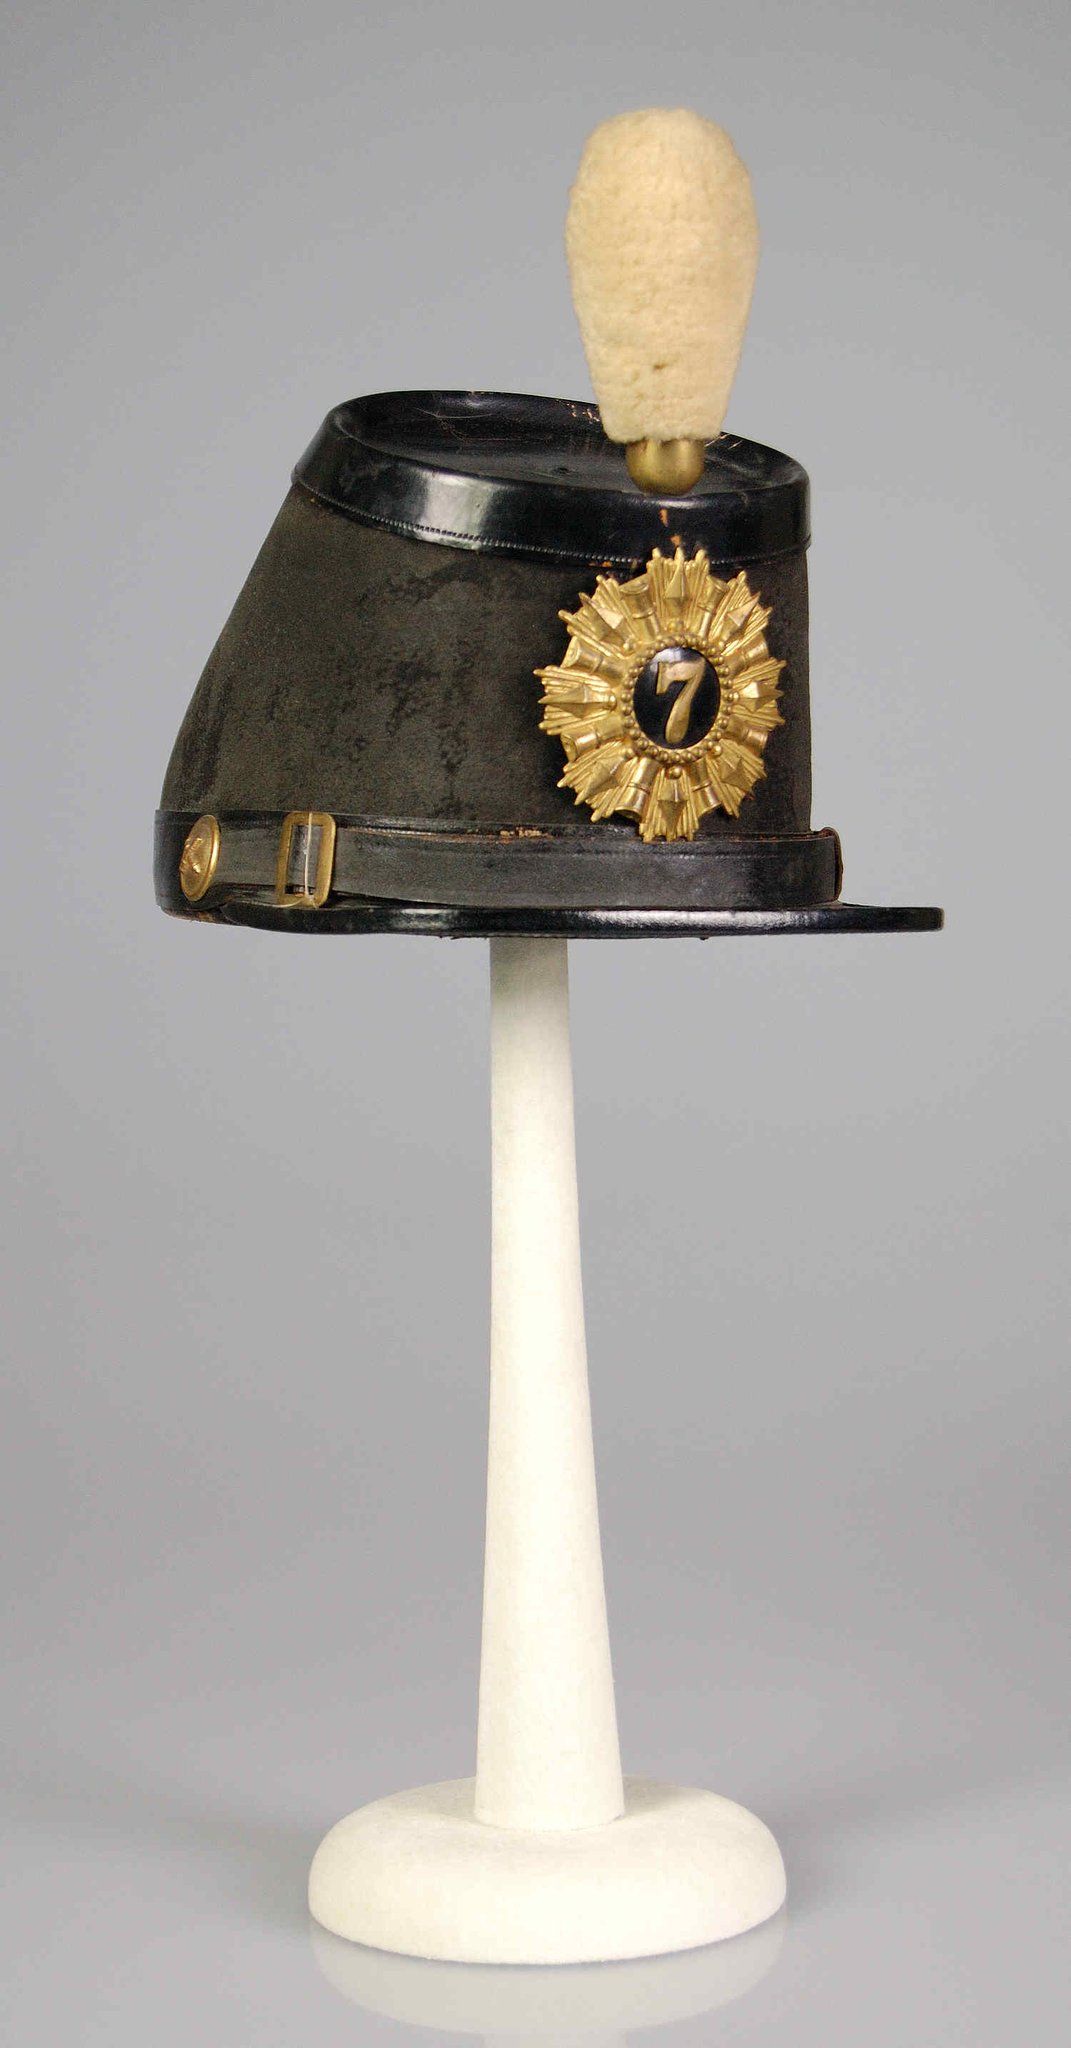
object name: military hat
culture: american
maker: j.h. mckenney & company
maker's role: manufacturer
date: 1860-1864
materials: leather, wool